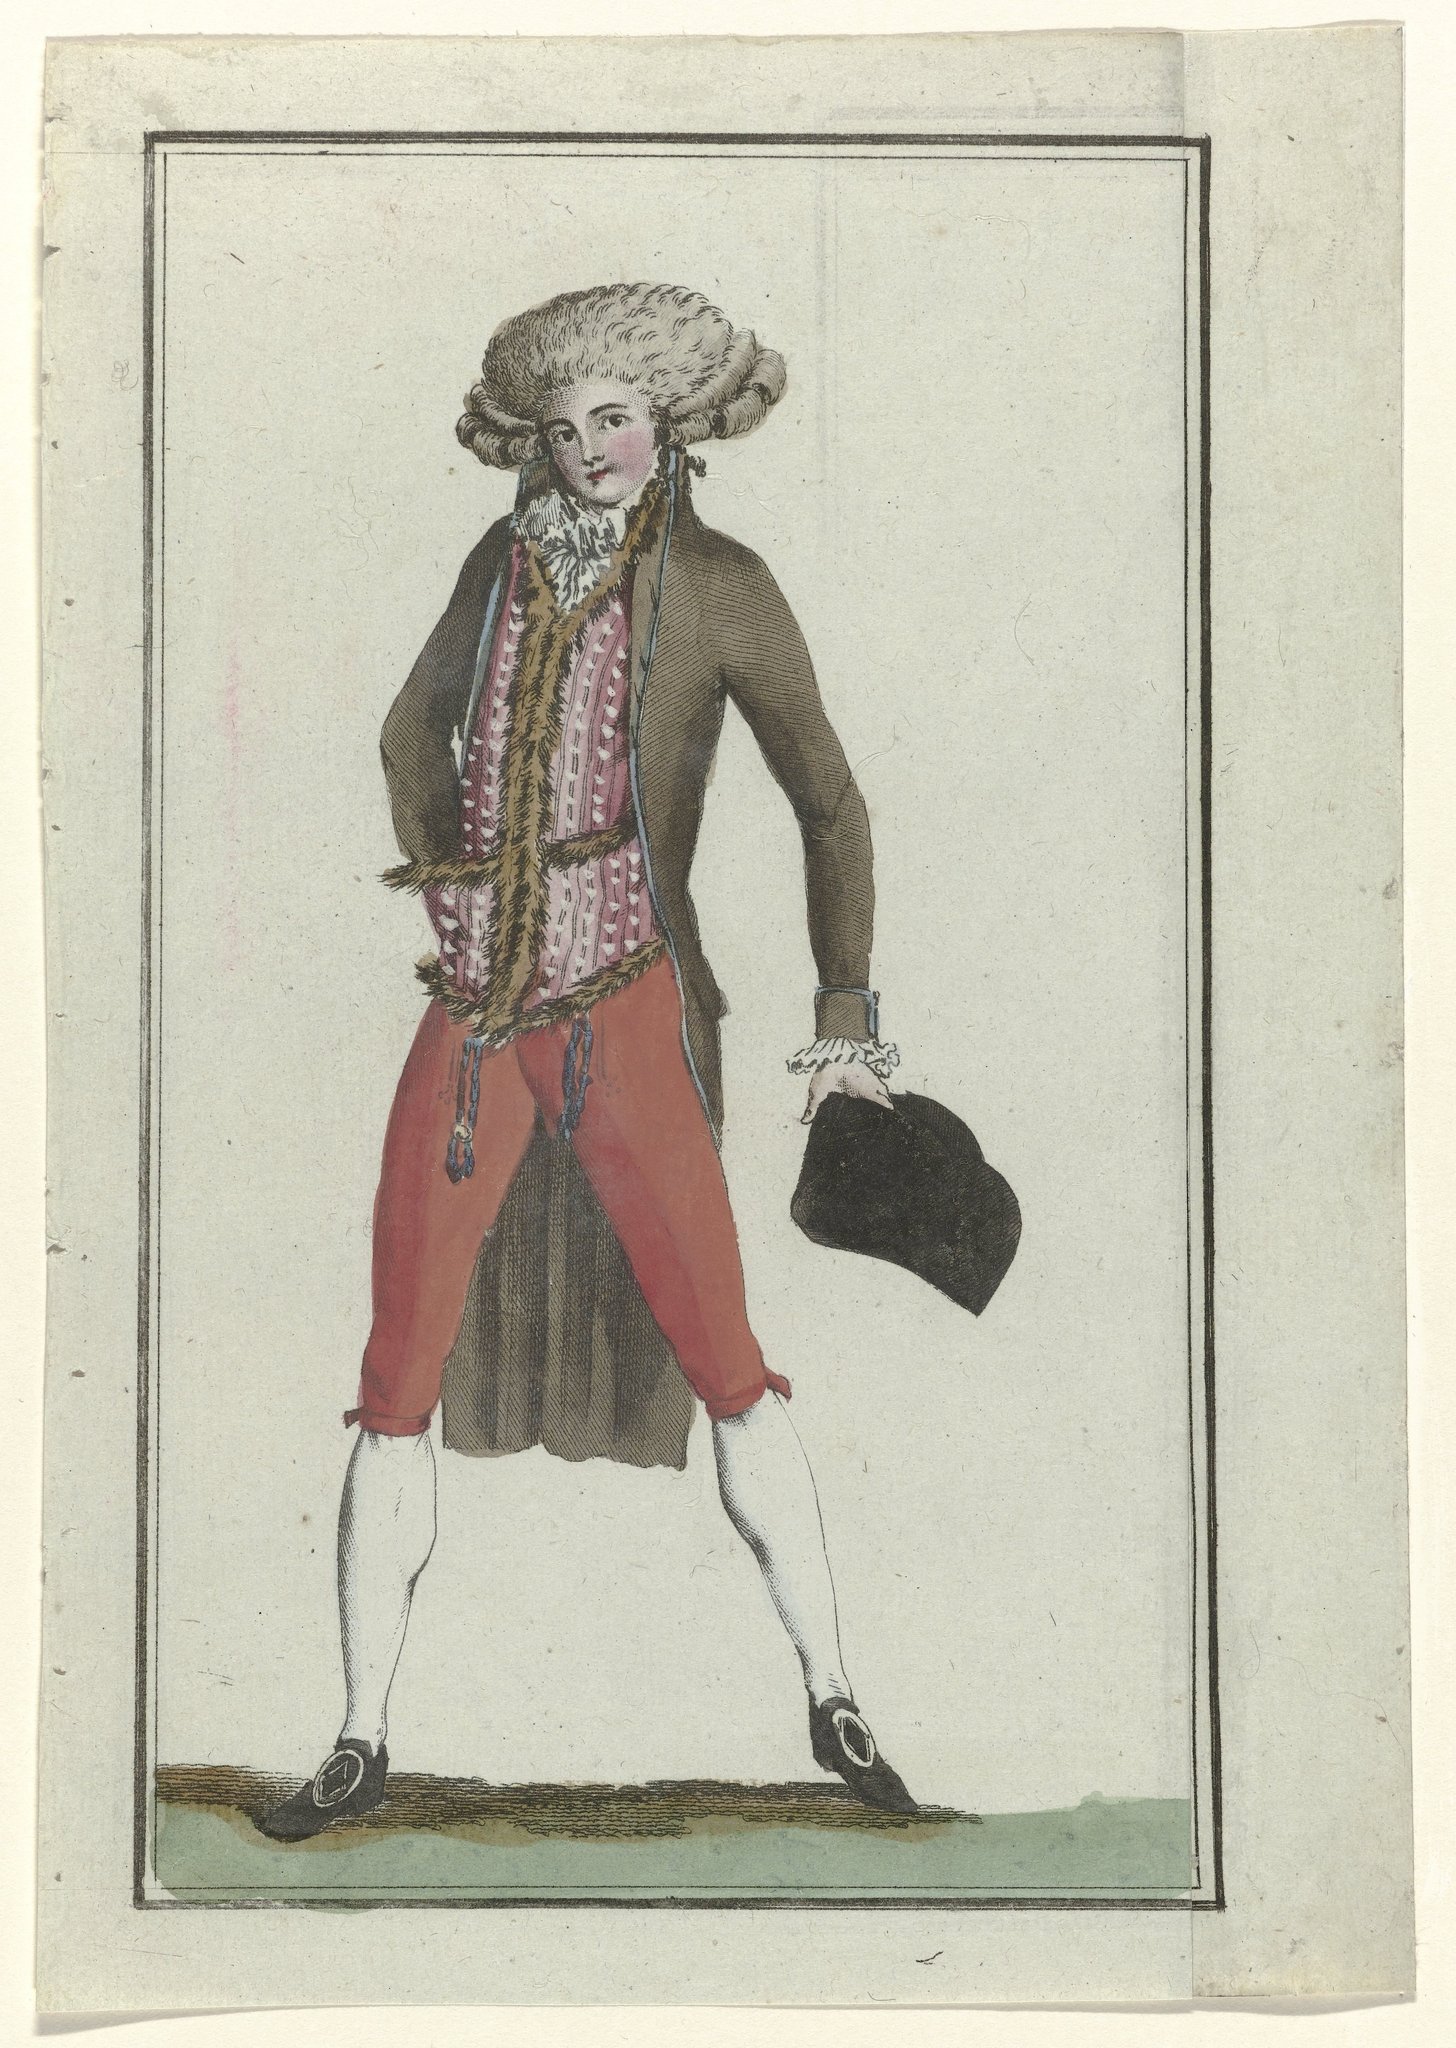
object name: fashion print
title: Fashion News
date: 1788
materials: paper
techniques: engraving, hand coloring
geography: paris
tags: clothing for the upper part of the body (vest) (+ men's clothes), neck-gear ~ clothing (+ men's clothes), border, ribbon, braid (+ fur used for clothes), coat (+ men's clothes), head-gear: hat (+ men's clothes), styles of hairdress, fashion plates, shoes, sandals (+ men's clothes), trousers, breeches, etc. (breeches) (+ men's clothes)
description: The Cabinet des Modes offered readers highly detailed information about the illustrated clothes and accessories. It reported, for instance, on new clothing styles, such as the English ‘redingote’ 1; on accessories and embellishments, such as oversized muffs, buttons, ribbons and clasps; and finally, on the latest interior furnishings. For its male audience there was the fitted jacket 2 and the popular Androsmane, a hat with an upturned brim 3.